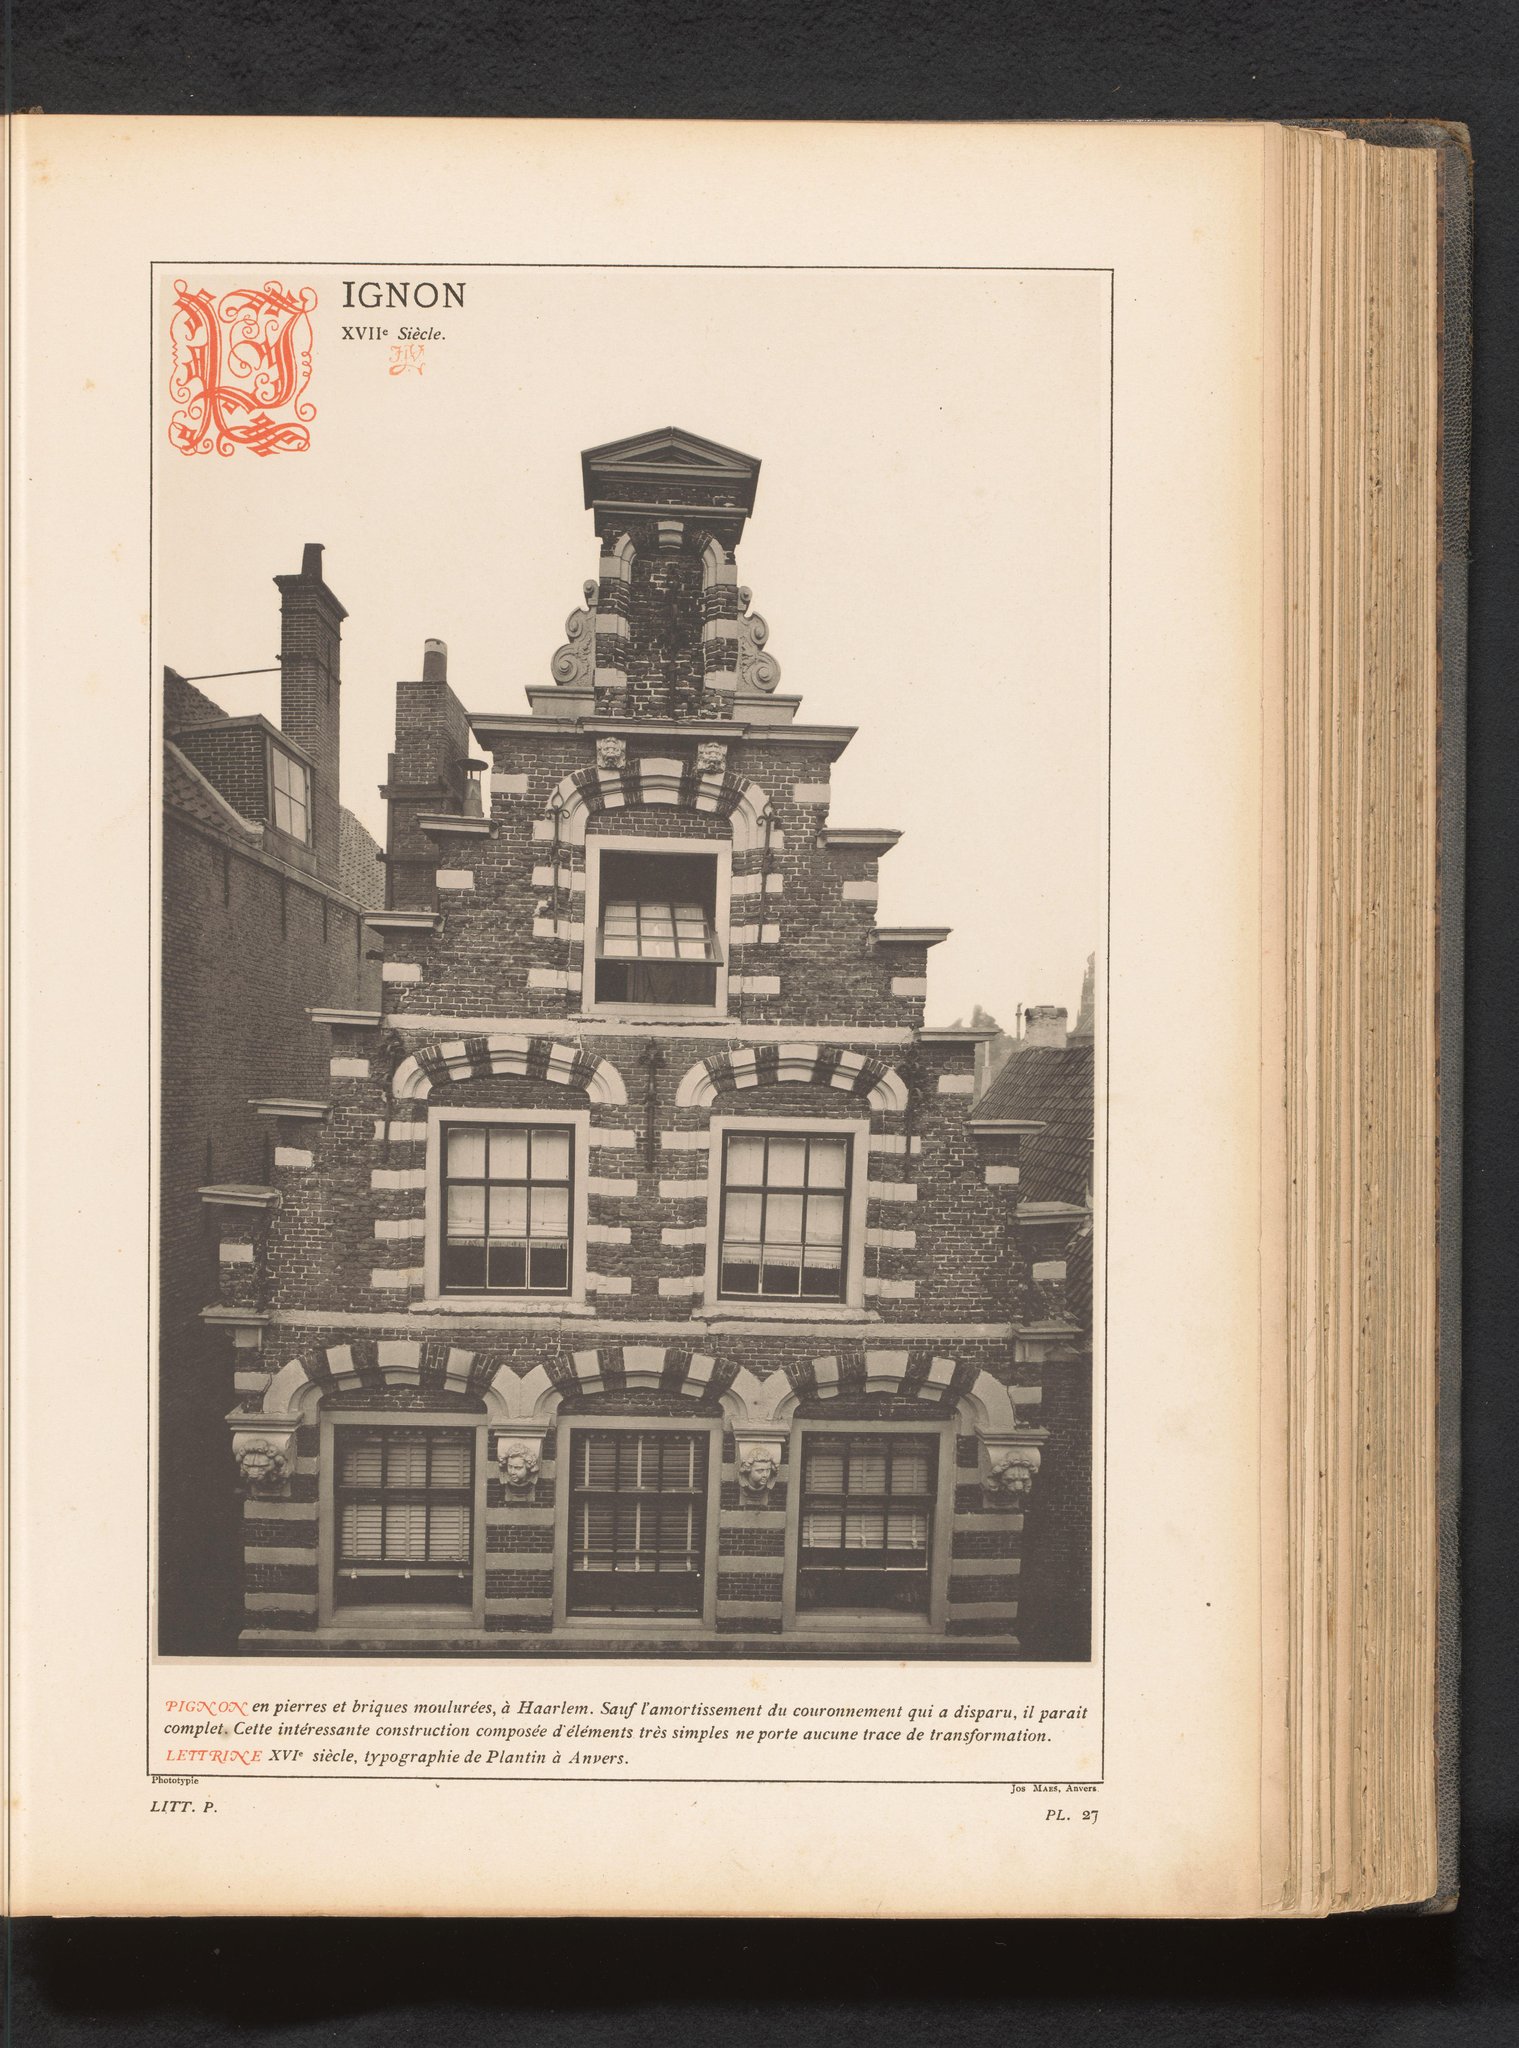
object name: page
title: Porte, XVIIe Siècle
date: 1876-1881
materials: paper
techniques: photograph, photolithography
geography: antwerp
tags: decorated gable, haarlem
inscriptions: inscription: ‘PIGNON en pierres (...)’, monogram: ‘JJvY’, inscription: ‘LITT. P. - PL. 27.’